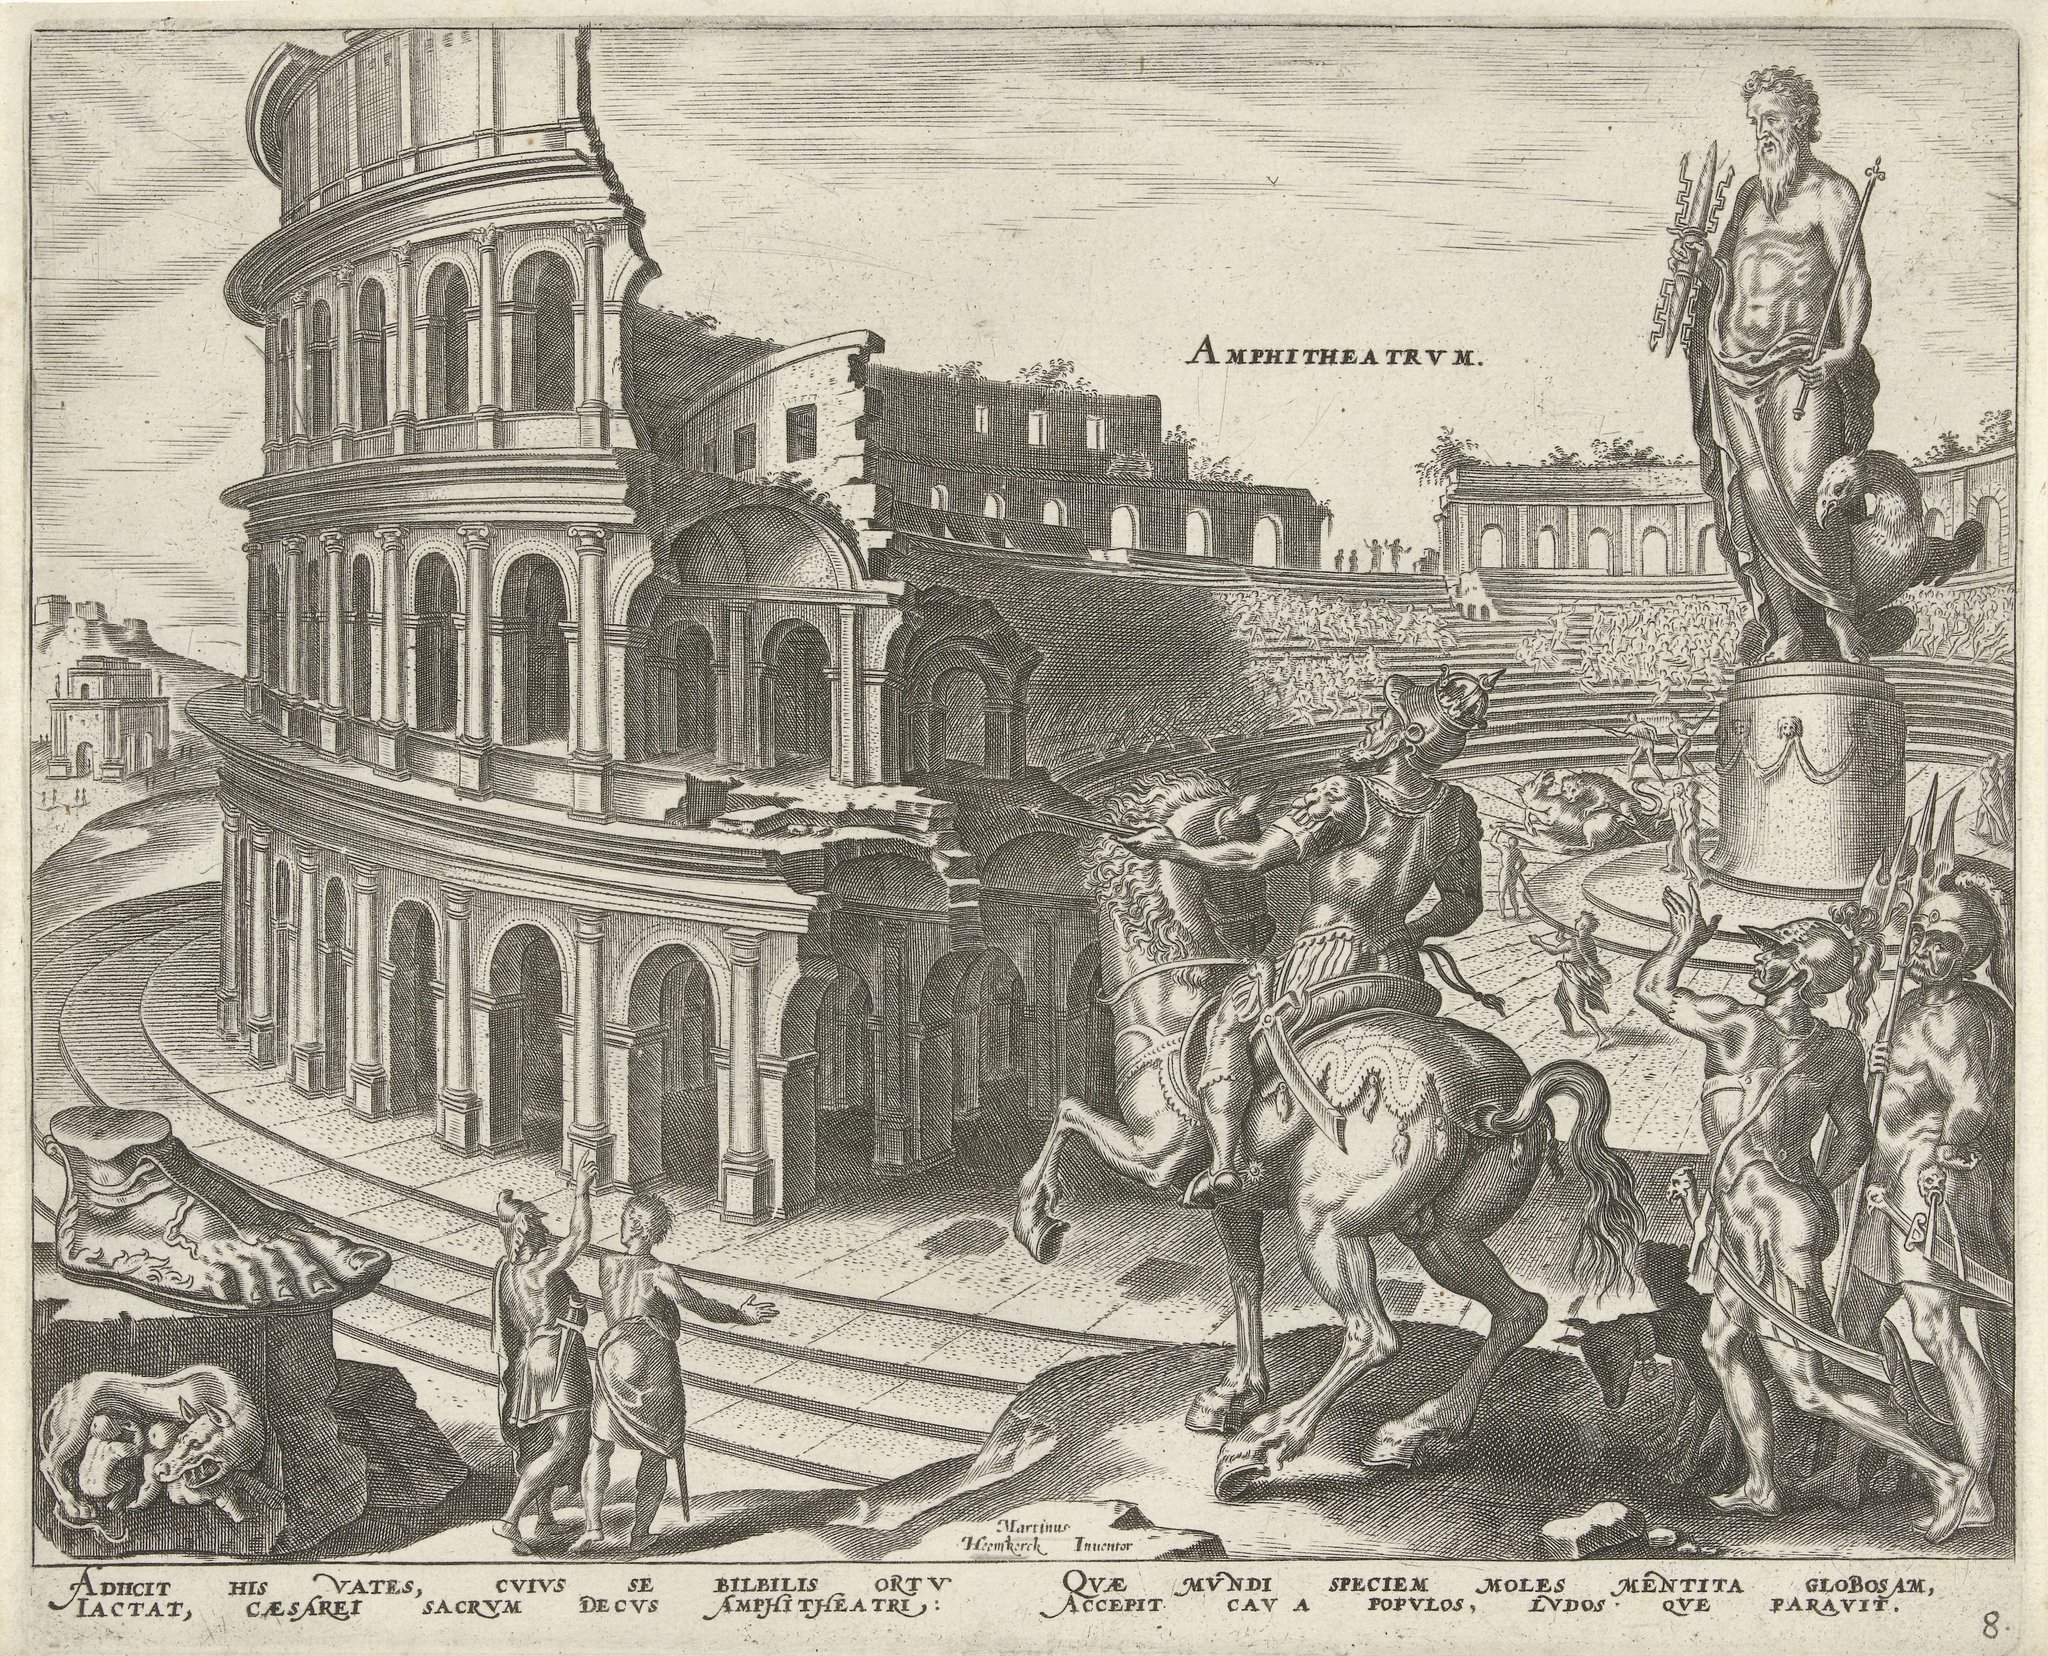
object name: print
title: Colosseum in Rome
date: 1572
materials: paper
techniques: engraving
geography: haarlem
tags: amphitheatre, vespasian builds the colosseum, other monuments which are sometimes included in the wonders of the world (colosseum), rome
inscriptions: collector's mark: Lugt 2228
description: De ruïne van het Romeins colosseum. Centraal in het colosseum een standbeeld van Jupiter. Er zijn gevechten aan de gang. In de voorgrond keizer Vespasianus te paard. Hij had opdracht gegeven tot de bouw van het colosseum. Links in de voorgrond een reliëf met de zogende Romulus en Remus. De prent heeft een Latijns onderschrift en maakt deel uit van een serie over de acht wereldwonderen.